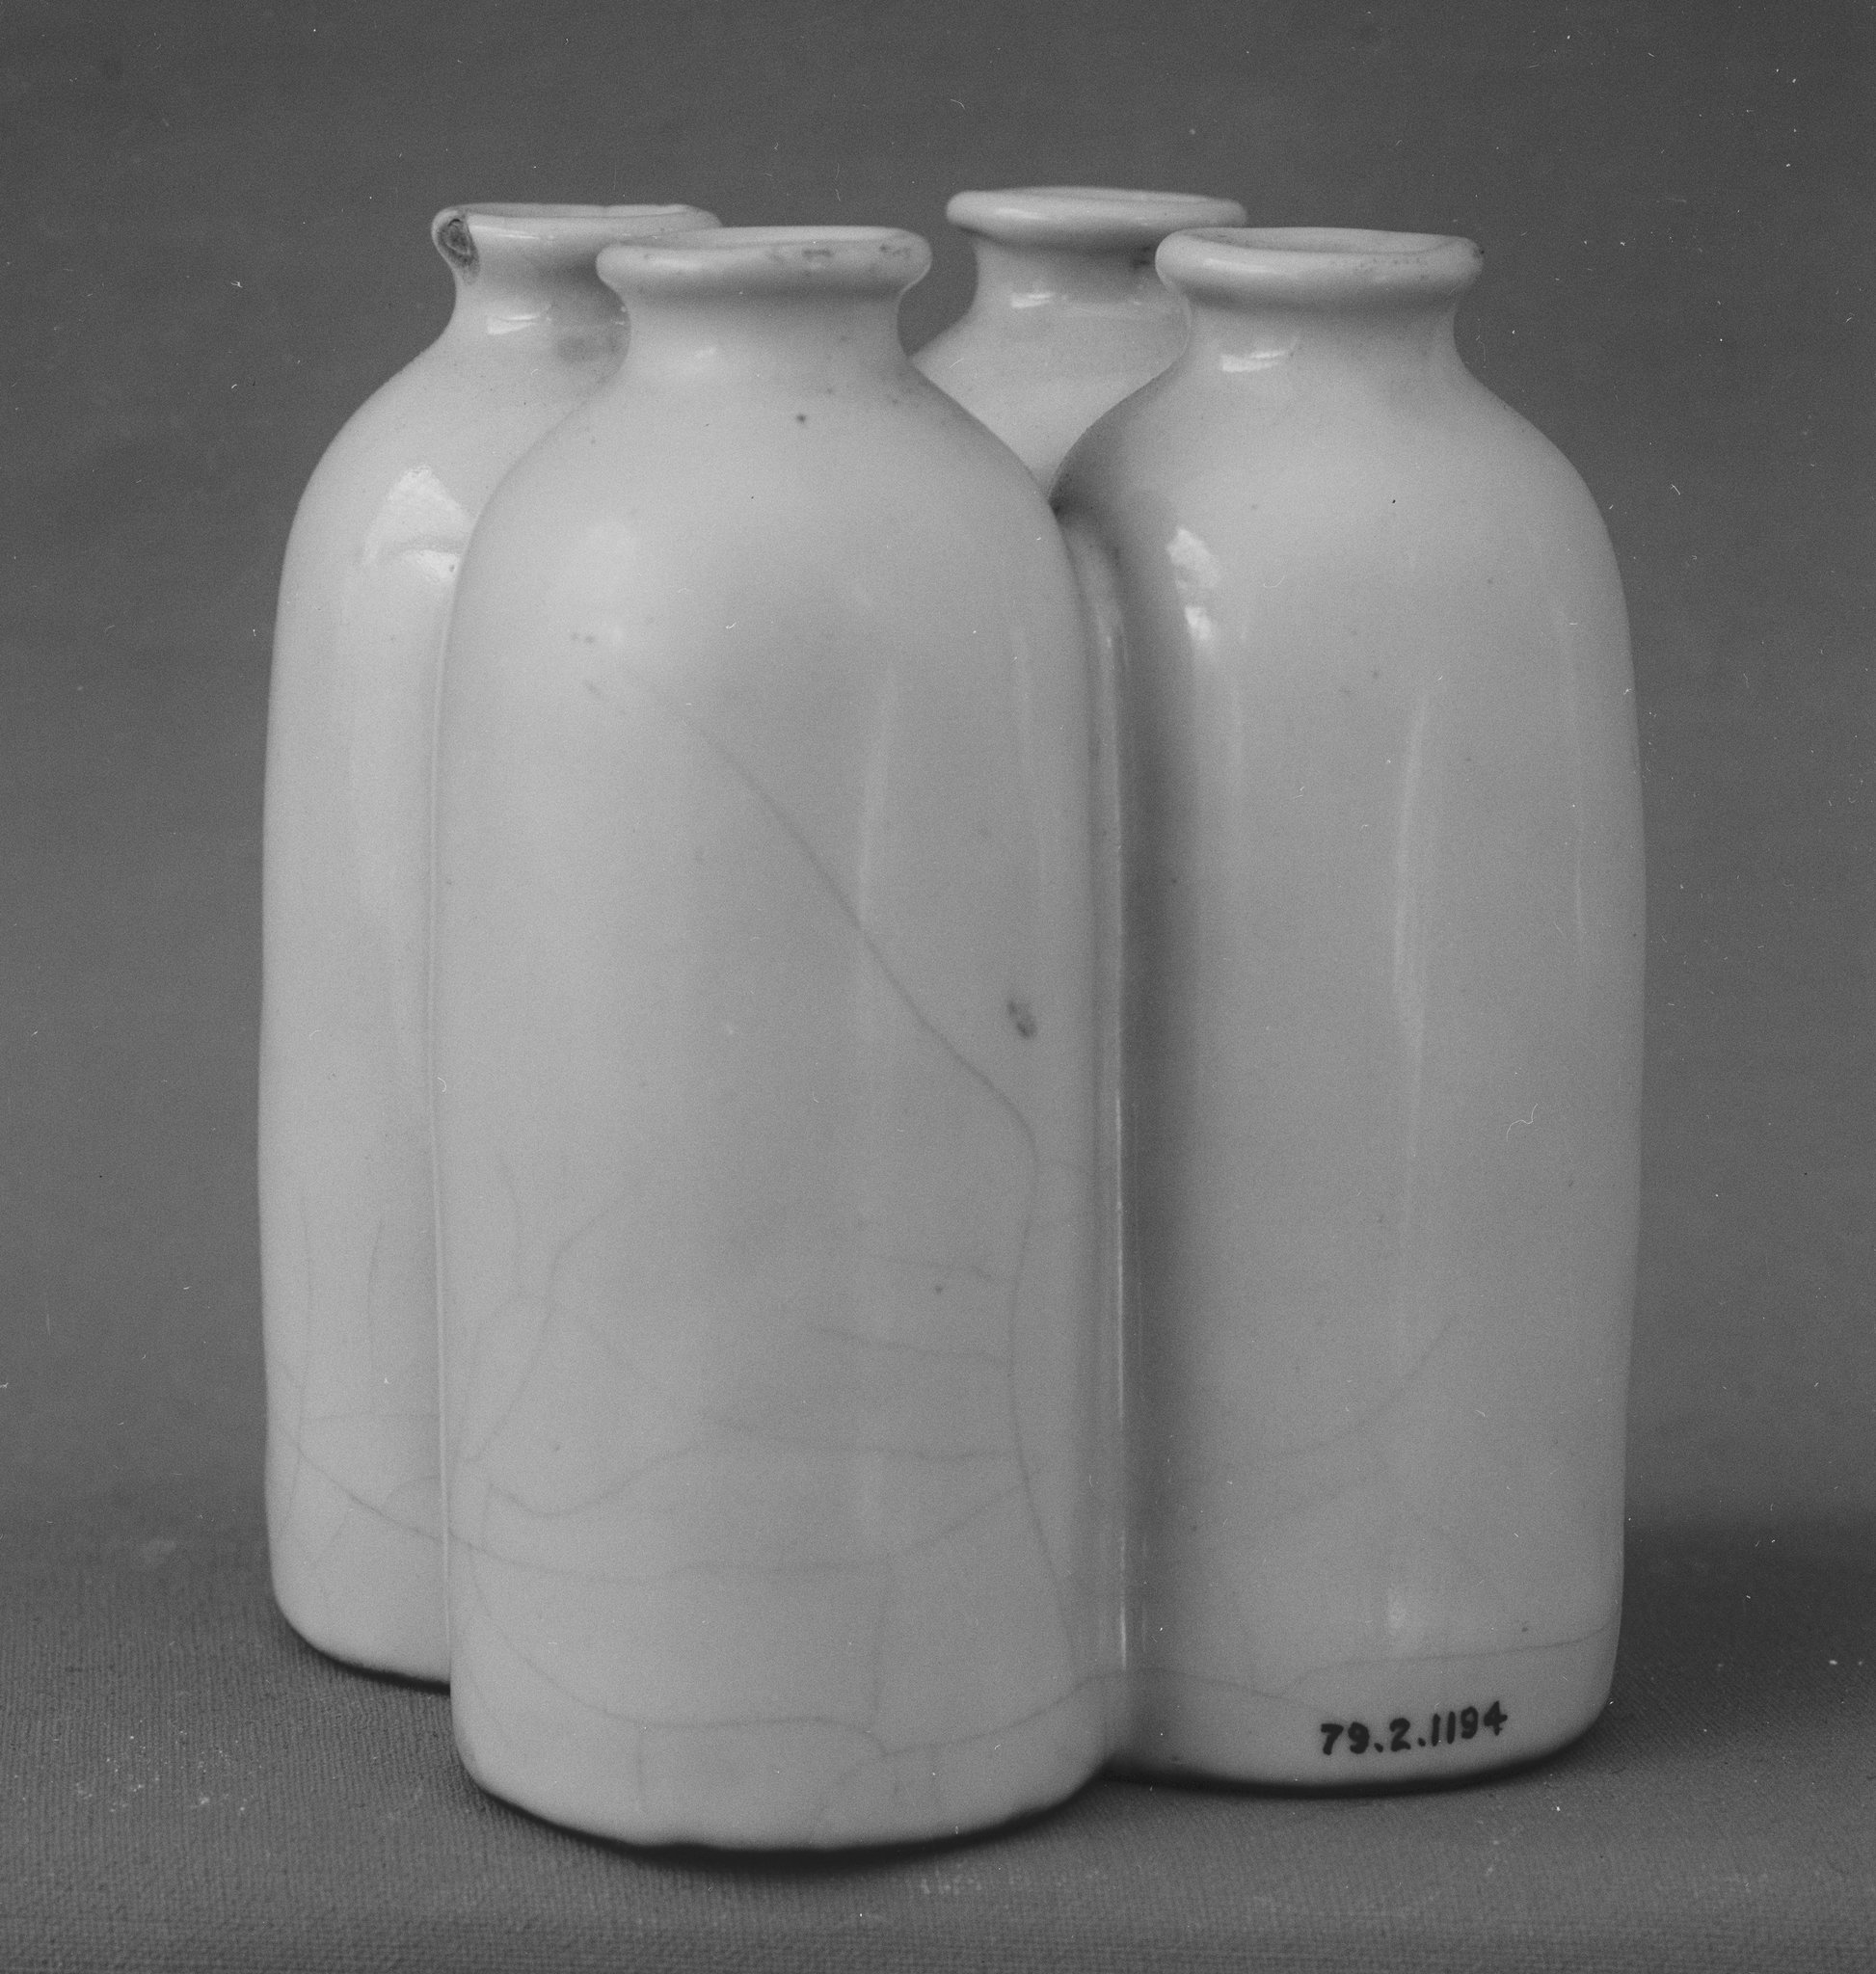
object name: vase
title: Quadruple Vase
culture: chinese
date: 1723-1735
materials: glaze, porcelain